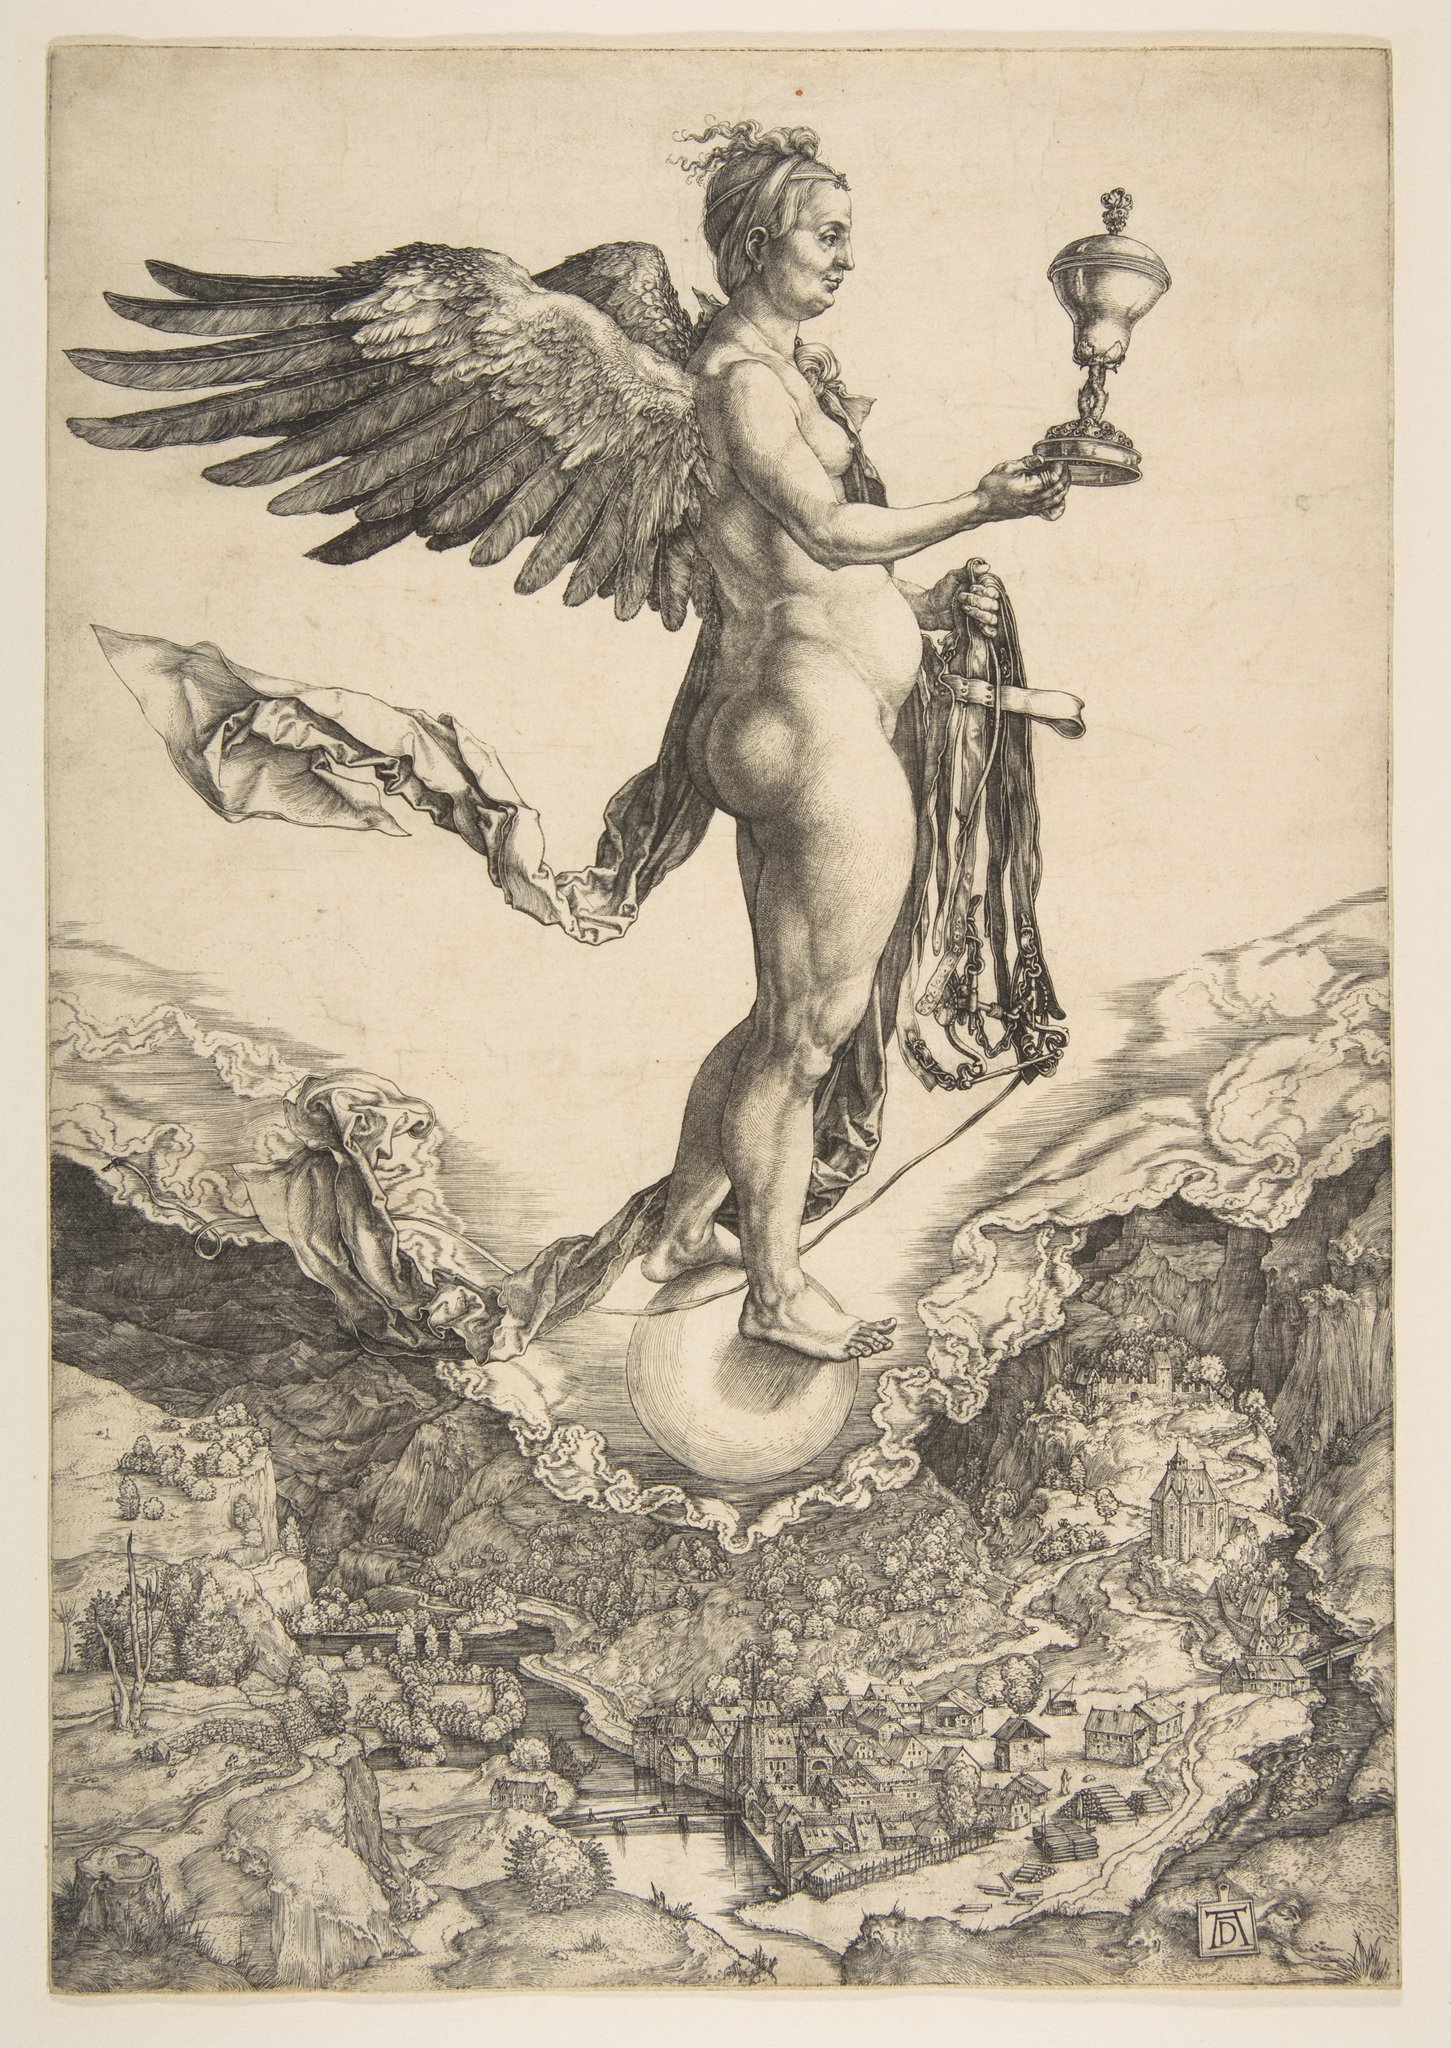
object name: print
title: Nemesis (The Great Fortune)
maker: albrecht dürer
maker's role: artist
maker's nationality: german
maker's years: 1471-1528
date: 1501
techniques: engraving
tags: female nudes